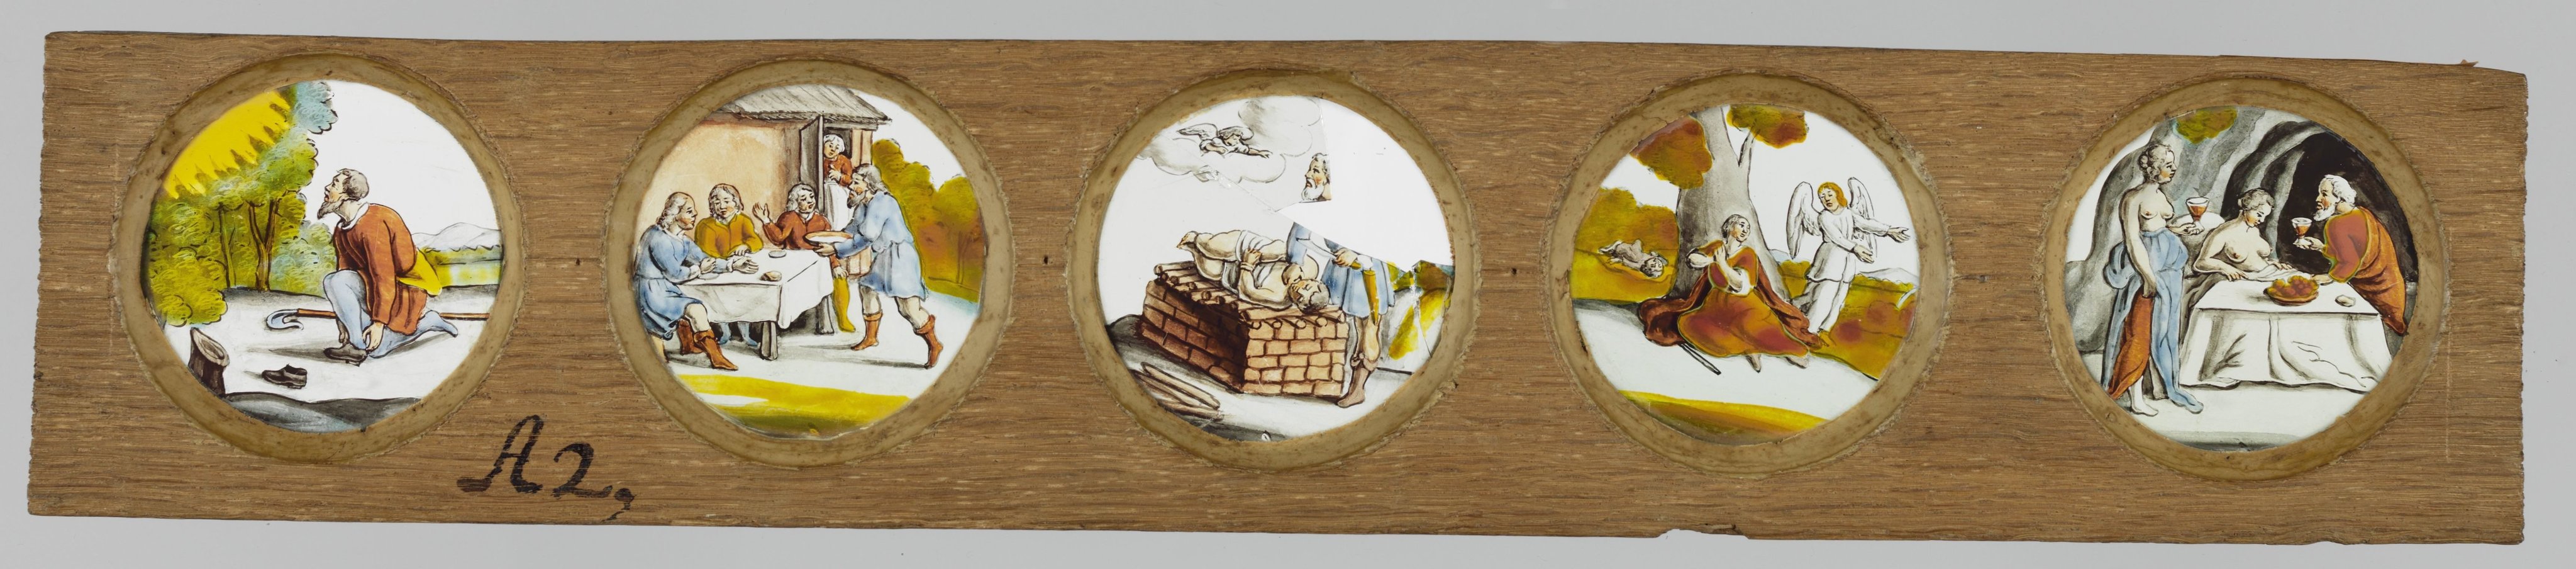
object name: lantern slide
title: Vijf taferelen uit het Oude Testament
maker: Anonymous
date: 1700-1790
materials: glass, wood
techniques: painted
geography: netherlands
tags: moses taking off his sandals, an angel appears and reveals a well of water to hagar, abraham entertaining the three angels, when abraham has his hand raised to kill isaac, an angel restrains abraham's hand, lot's daughters make their father drunk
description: Vijf ronde glaasjes met taferelen uit het Oude Testament in een houten vatting. Het glas uiterst links: Mozes doet zijn schoenen uit bij de brandende braamstruik, hier verbeeld als een lichtgevende bol tussen de bomen. Het glas rechts daarvan: mannen rond een gedekte tafel voor een huis, een man draagt een grote kom voedsel aan terwijl vanuit de deur van het huis een vrouw toekijkt. (Vermoedelijk Abraham die de drie engelen ontvangt. Sara staat in de deuropening.) Het glas in het midden: Abraham heft het mes om Isaak te offeren, een engel komt vanuit de wolken om hem ervan te weerhouden. Het glas rechts daarvan: Hagar in ballingschap bij een bron in de woestijn, waar een engel haar vertelt terug te gaan. Hagar, in rode kleding, zit tegen een boom, de engel rechts van haar wijst met beide handen de verte in. Uiterst rechts: de dochters van Lot voeren hun vader dronken. Lot rechts, zijn beide dochters met ontbloot bovenlijf links. Op de voorgrond een tafel met wit tafellaken. Het tafereel vindt plaats in een grot.